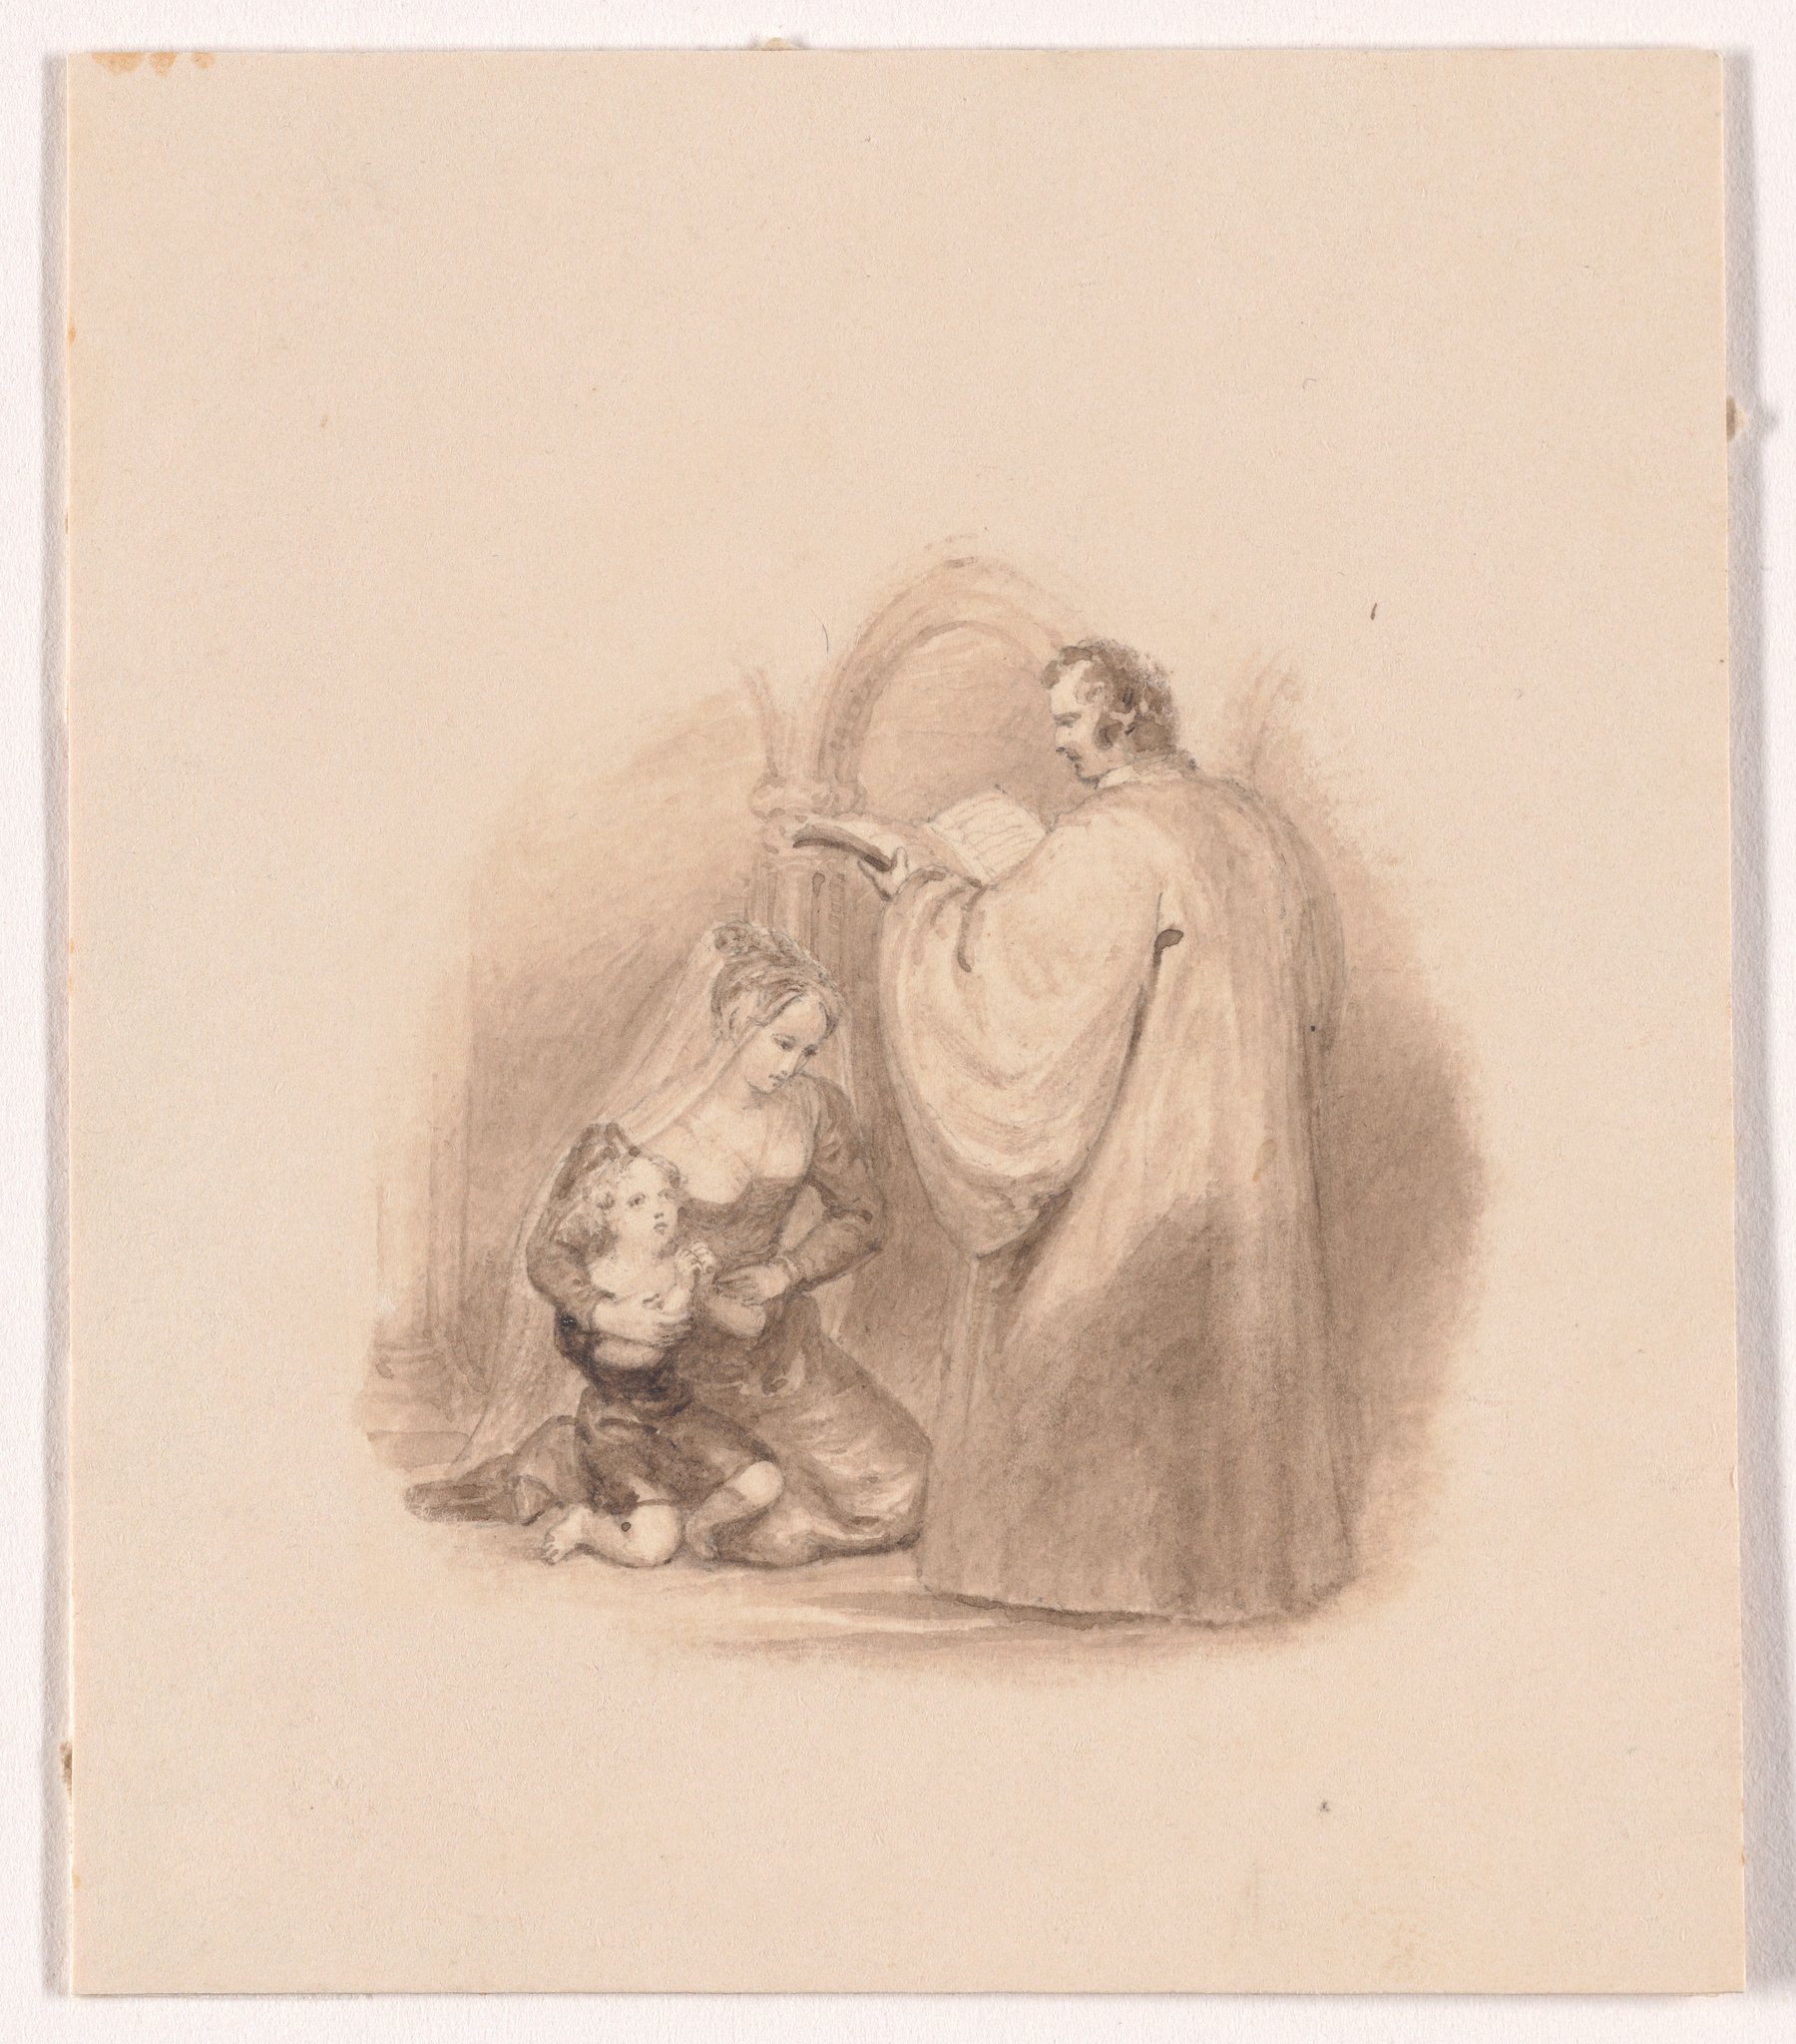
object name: drawing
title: Illustration design for "The Economy of Human Life"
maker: frank howard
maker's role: artist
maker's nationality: british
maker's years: 1805-1866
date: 1834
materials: ink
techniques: brush, pen, wash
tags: children,men,women